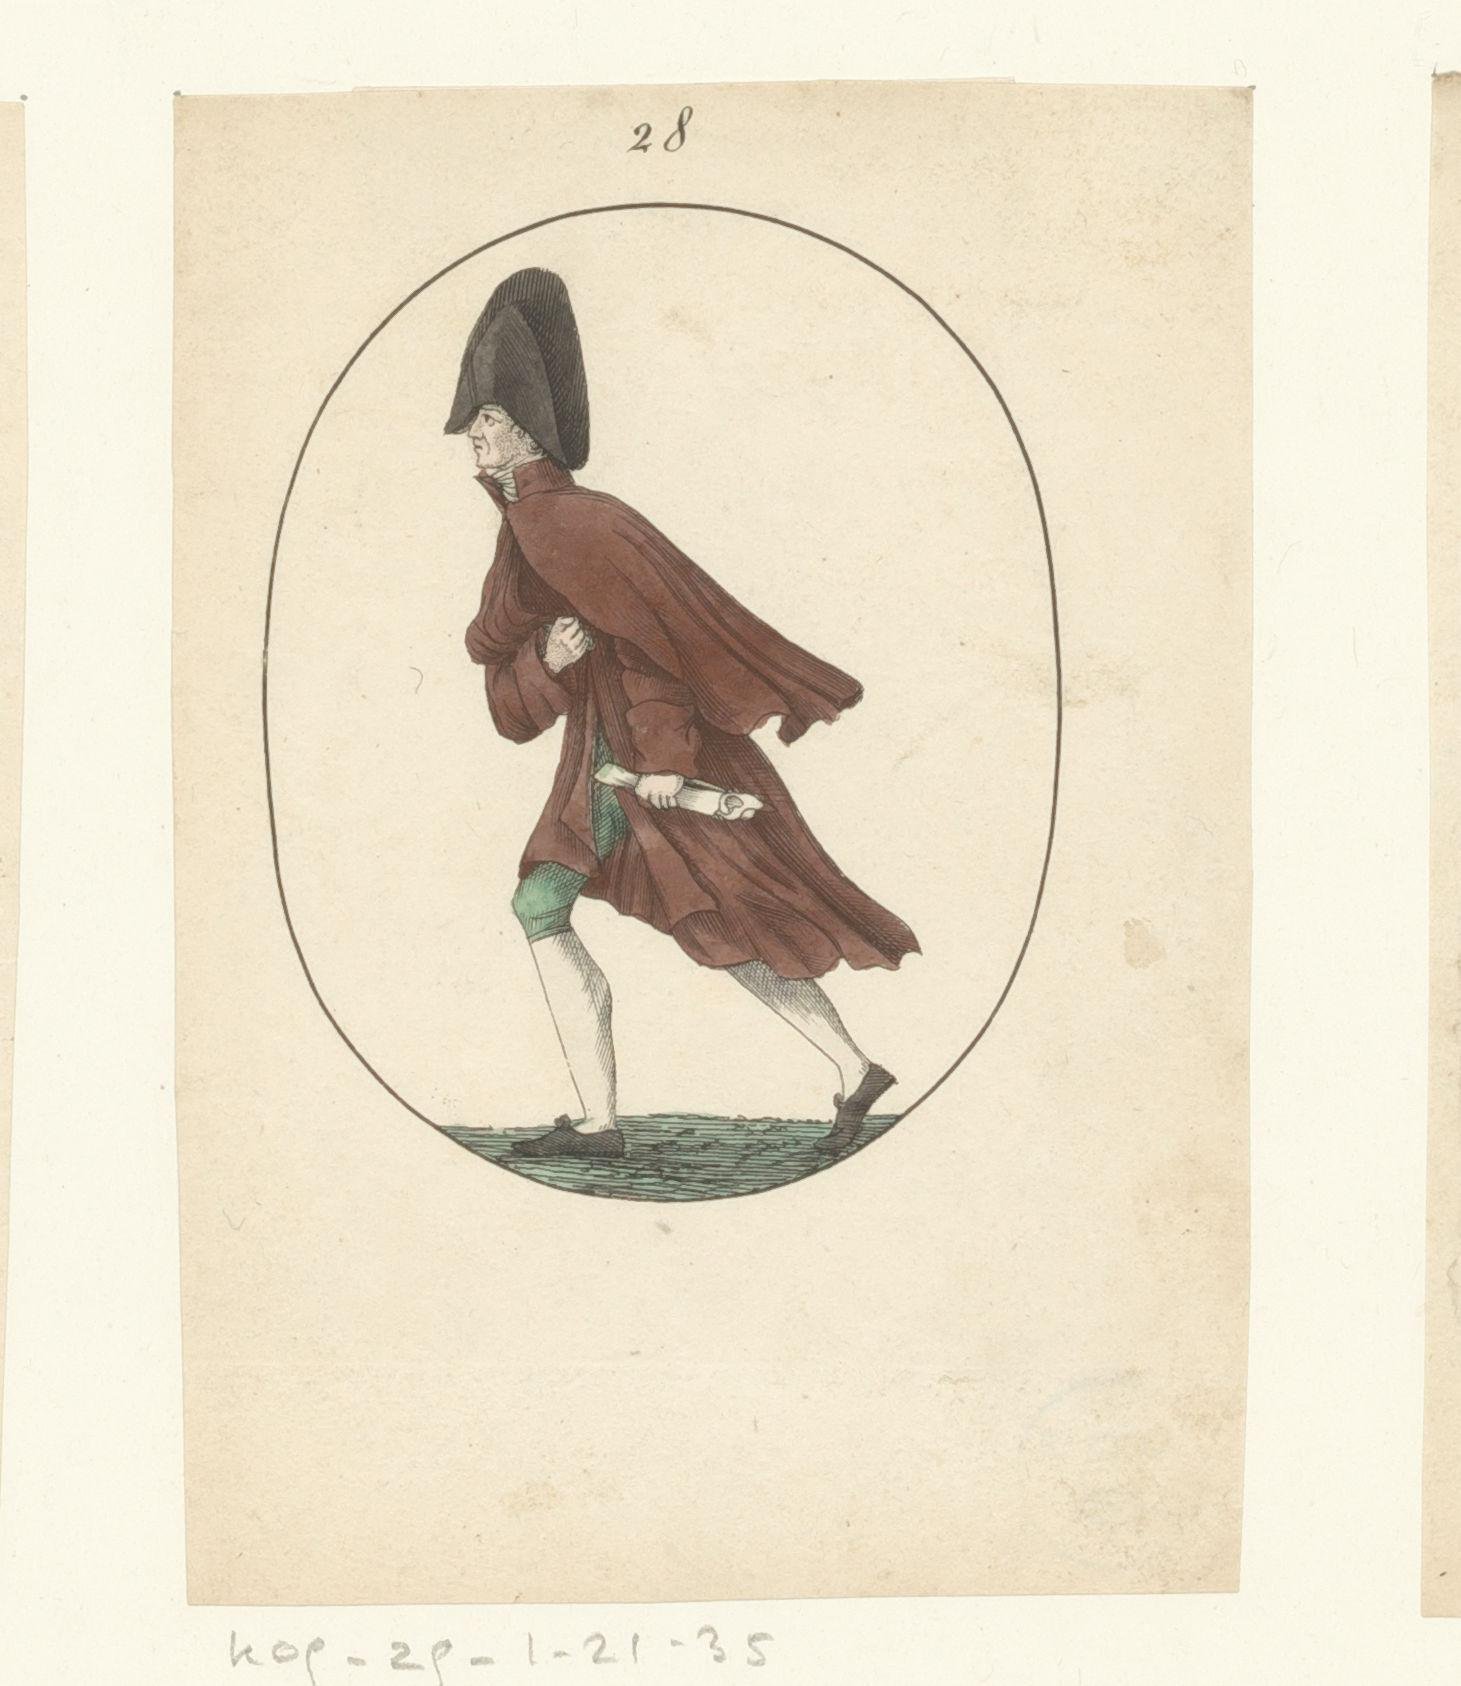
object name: print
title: Lopende man met papier in zijn hand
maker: Anonymous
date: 1750-1849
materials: paper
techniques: etching, hand coloring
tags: head-gear: bicorne, bicorn, running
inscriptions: stamp, collector's mark: Lugt 1641a, collector's mark: Lugt 1641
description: Bovenaan genummerd: 28. Onderwerpsrubrieken binnen de Atlas Zeden en Gewoonten: Zeden en Gewoonten in Engeren Zin, De Kleeding, Kleederdrachten (tijdvakken), De 18de eeuw (de pruikentijd). Mannen en vrouwen.